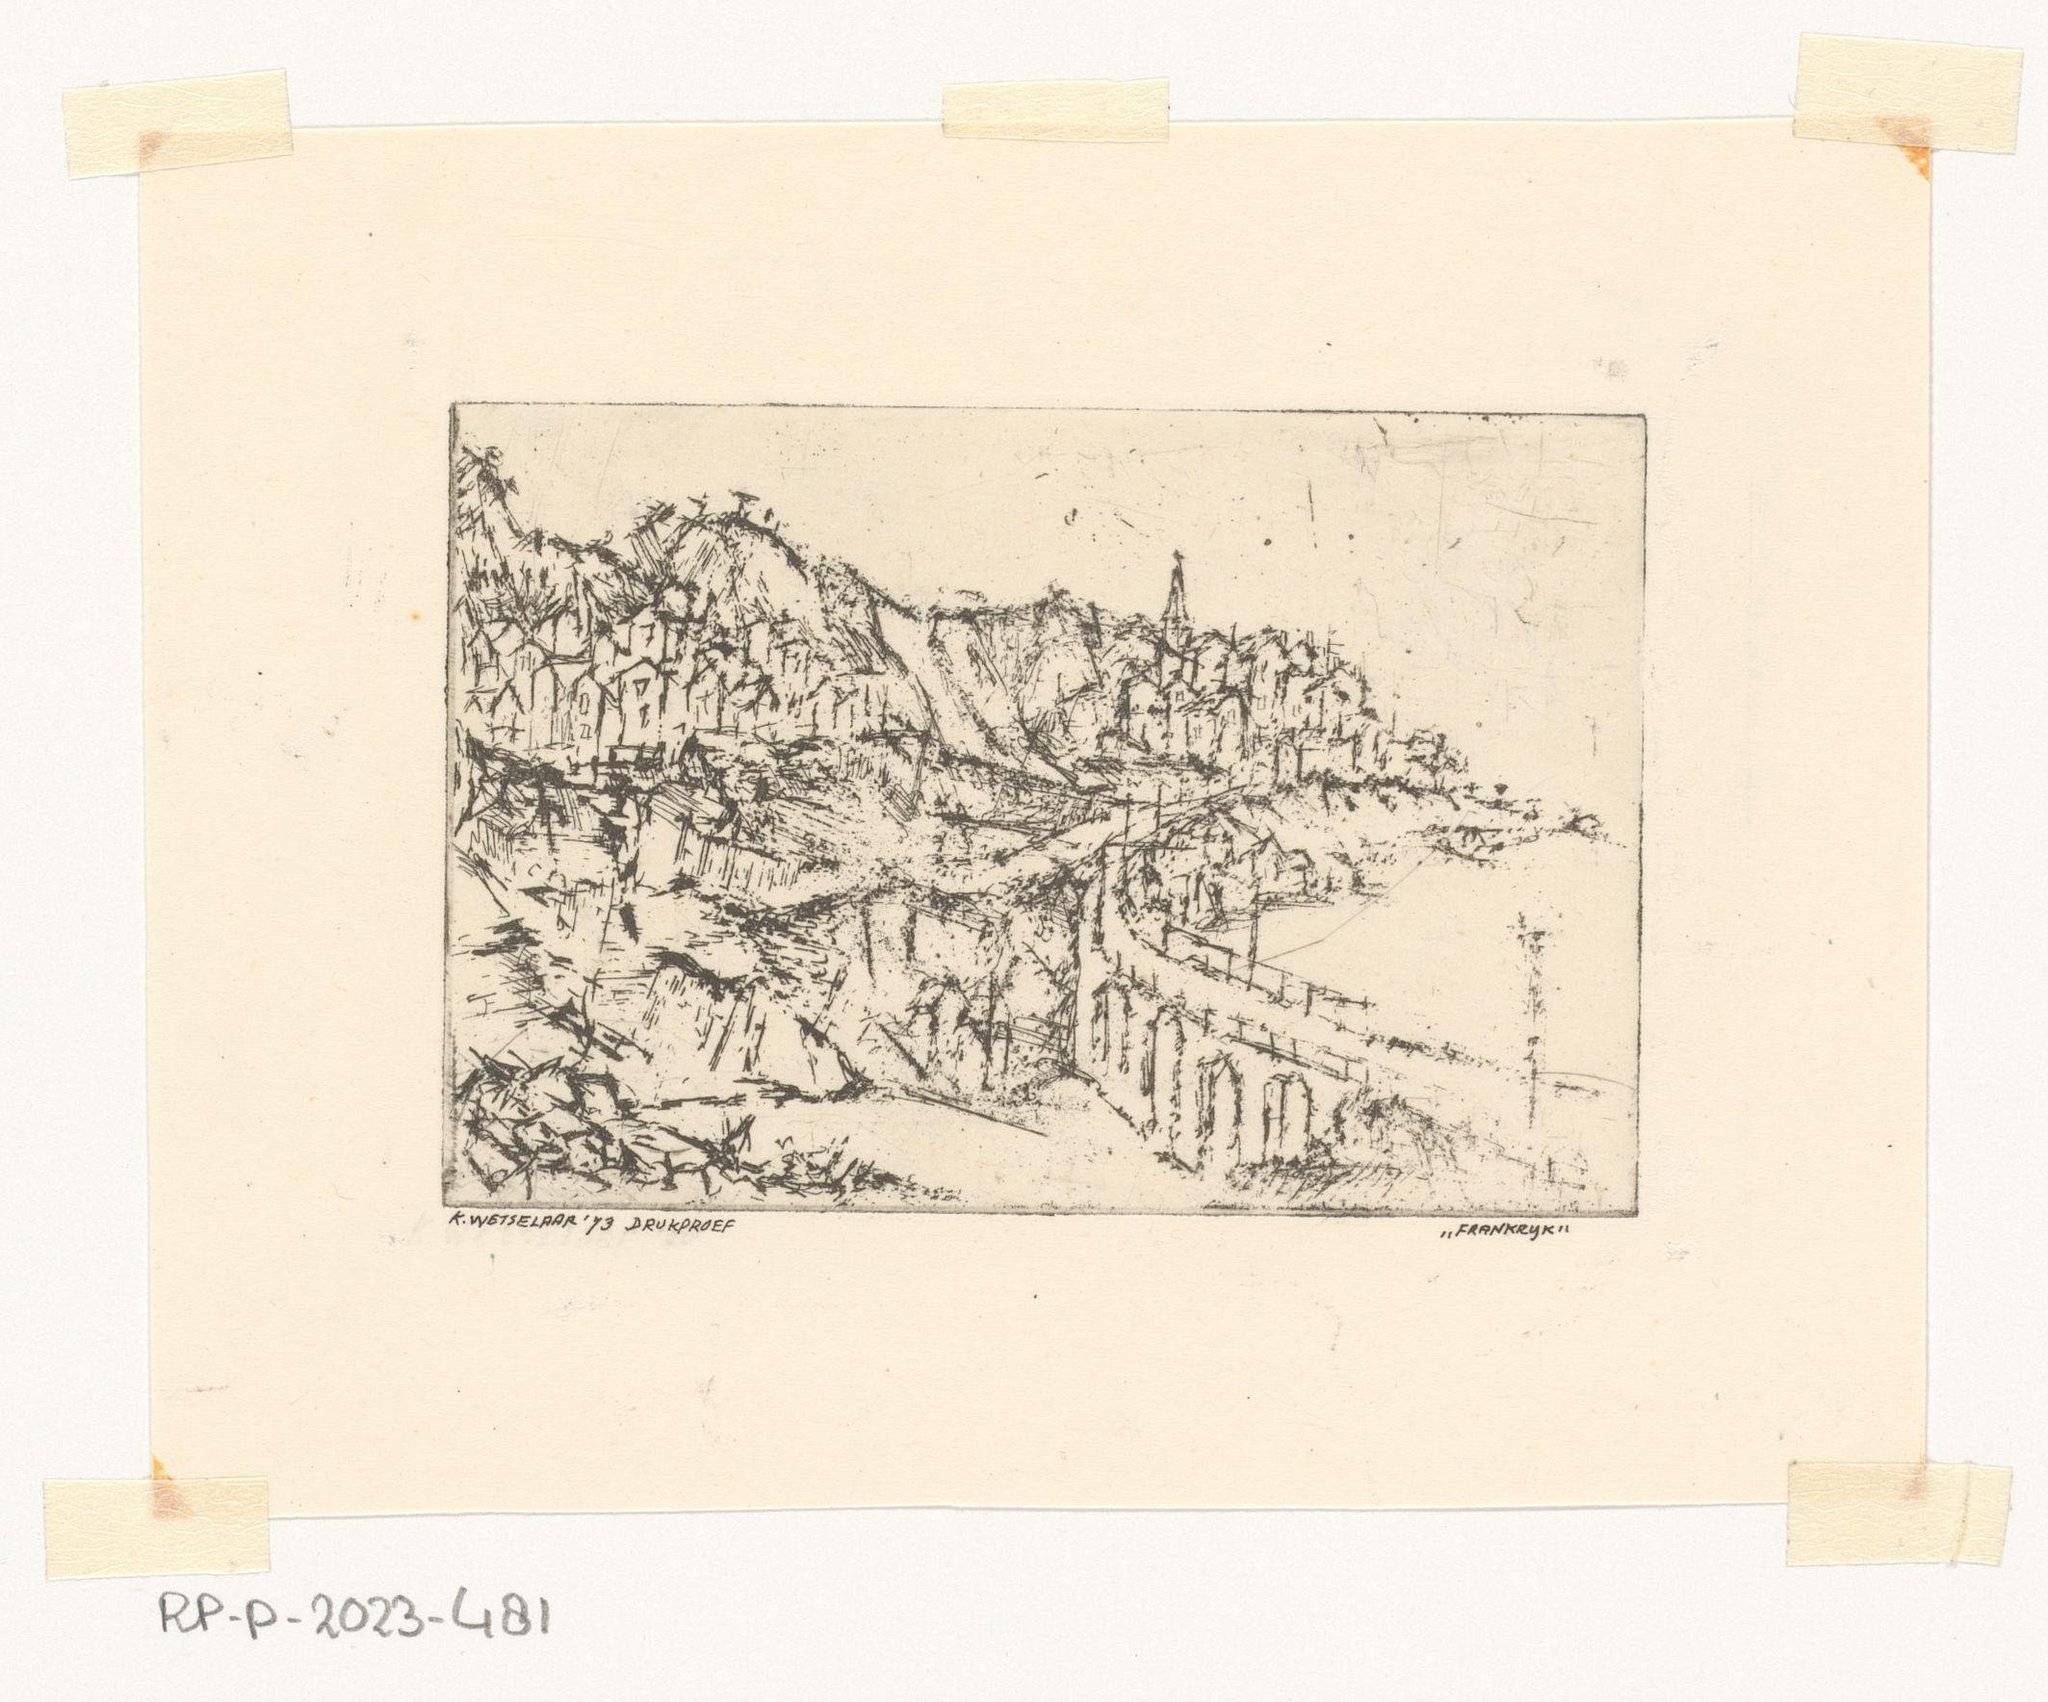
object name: print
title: Frankrijk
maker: karel wetselaar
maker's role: print maker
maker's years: 1935-2017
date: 1973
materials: paper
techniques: etching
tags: village, bridge in village across river, canal, etc.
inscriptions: inscription: ‘drukproef’, signature and date: ‘K. Wetselaar '73’